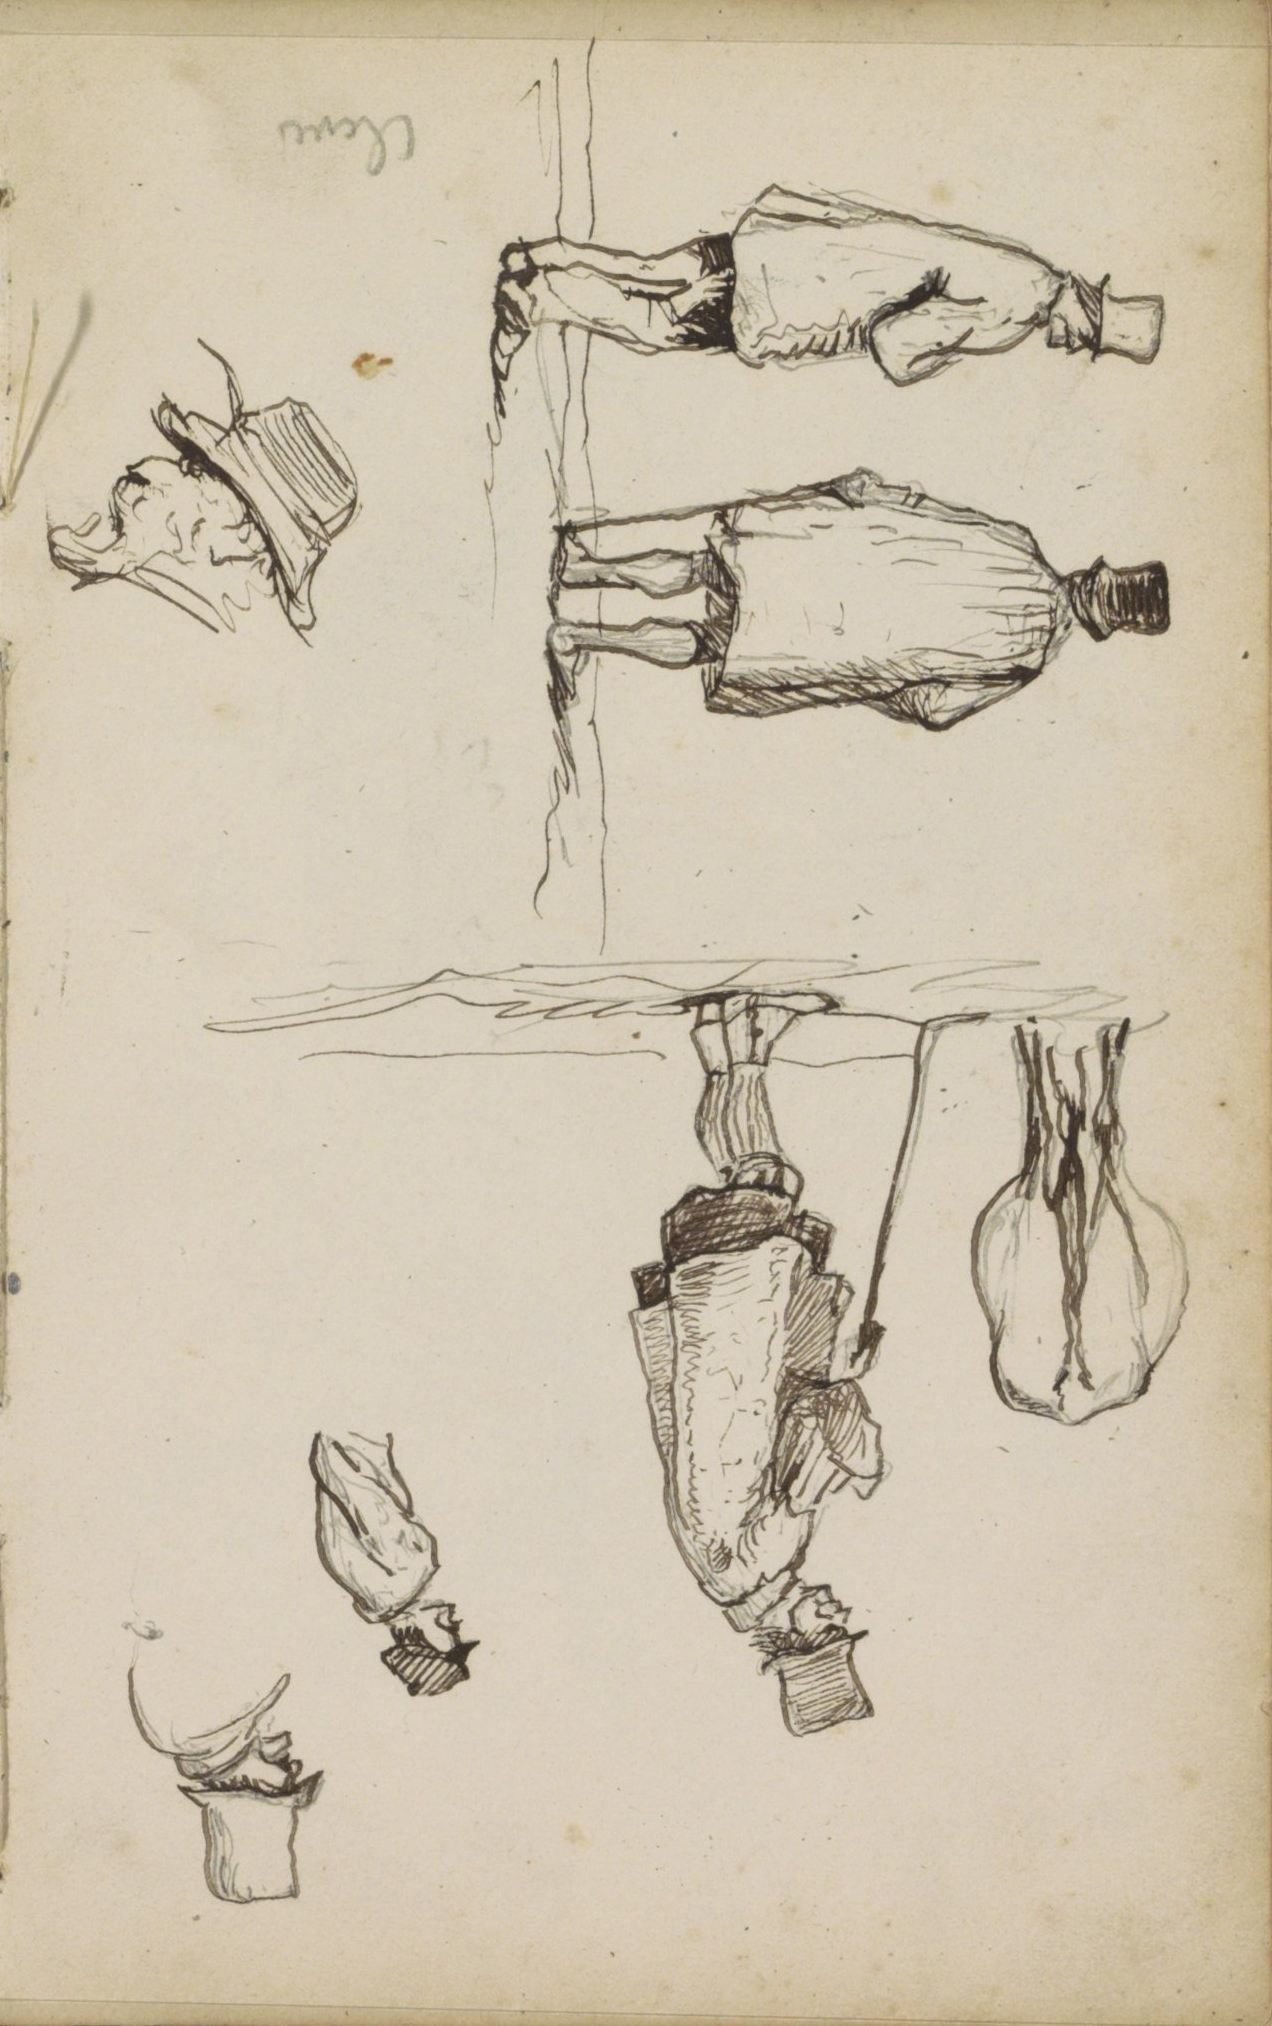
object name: sketchbook leaf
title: Mannenkoppen en mannen met hoge hoeden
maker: johannes tavenraat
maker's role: draughtsman, painter, print maker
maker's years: 1809-1881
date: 1839-1872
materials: ink, paper, pencil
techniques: pen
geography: cleves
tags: cow, walking-stick, staff, adult man, head-gear: top hat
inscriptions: annotation: ‘Cleve’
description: Tevens een studie van de achterkant van een koe. Blad 69 recto uit een schetsboek met 73 bladen.